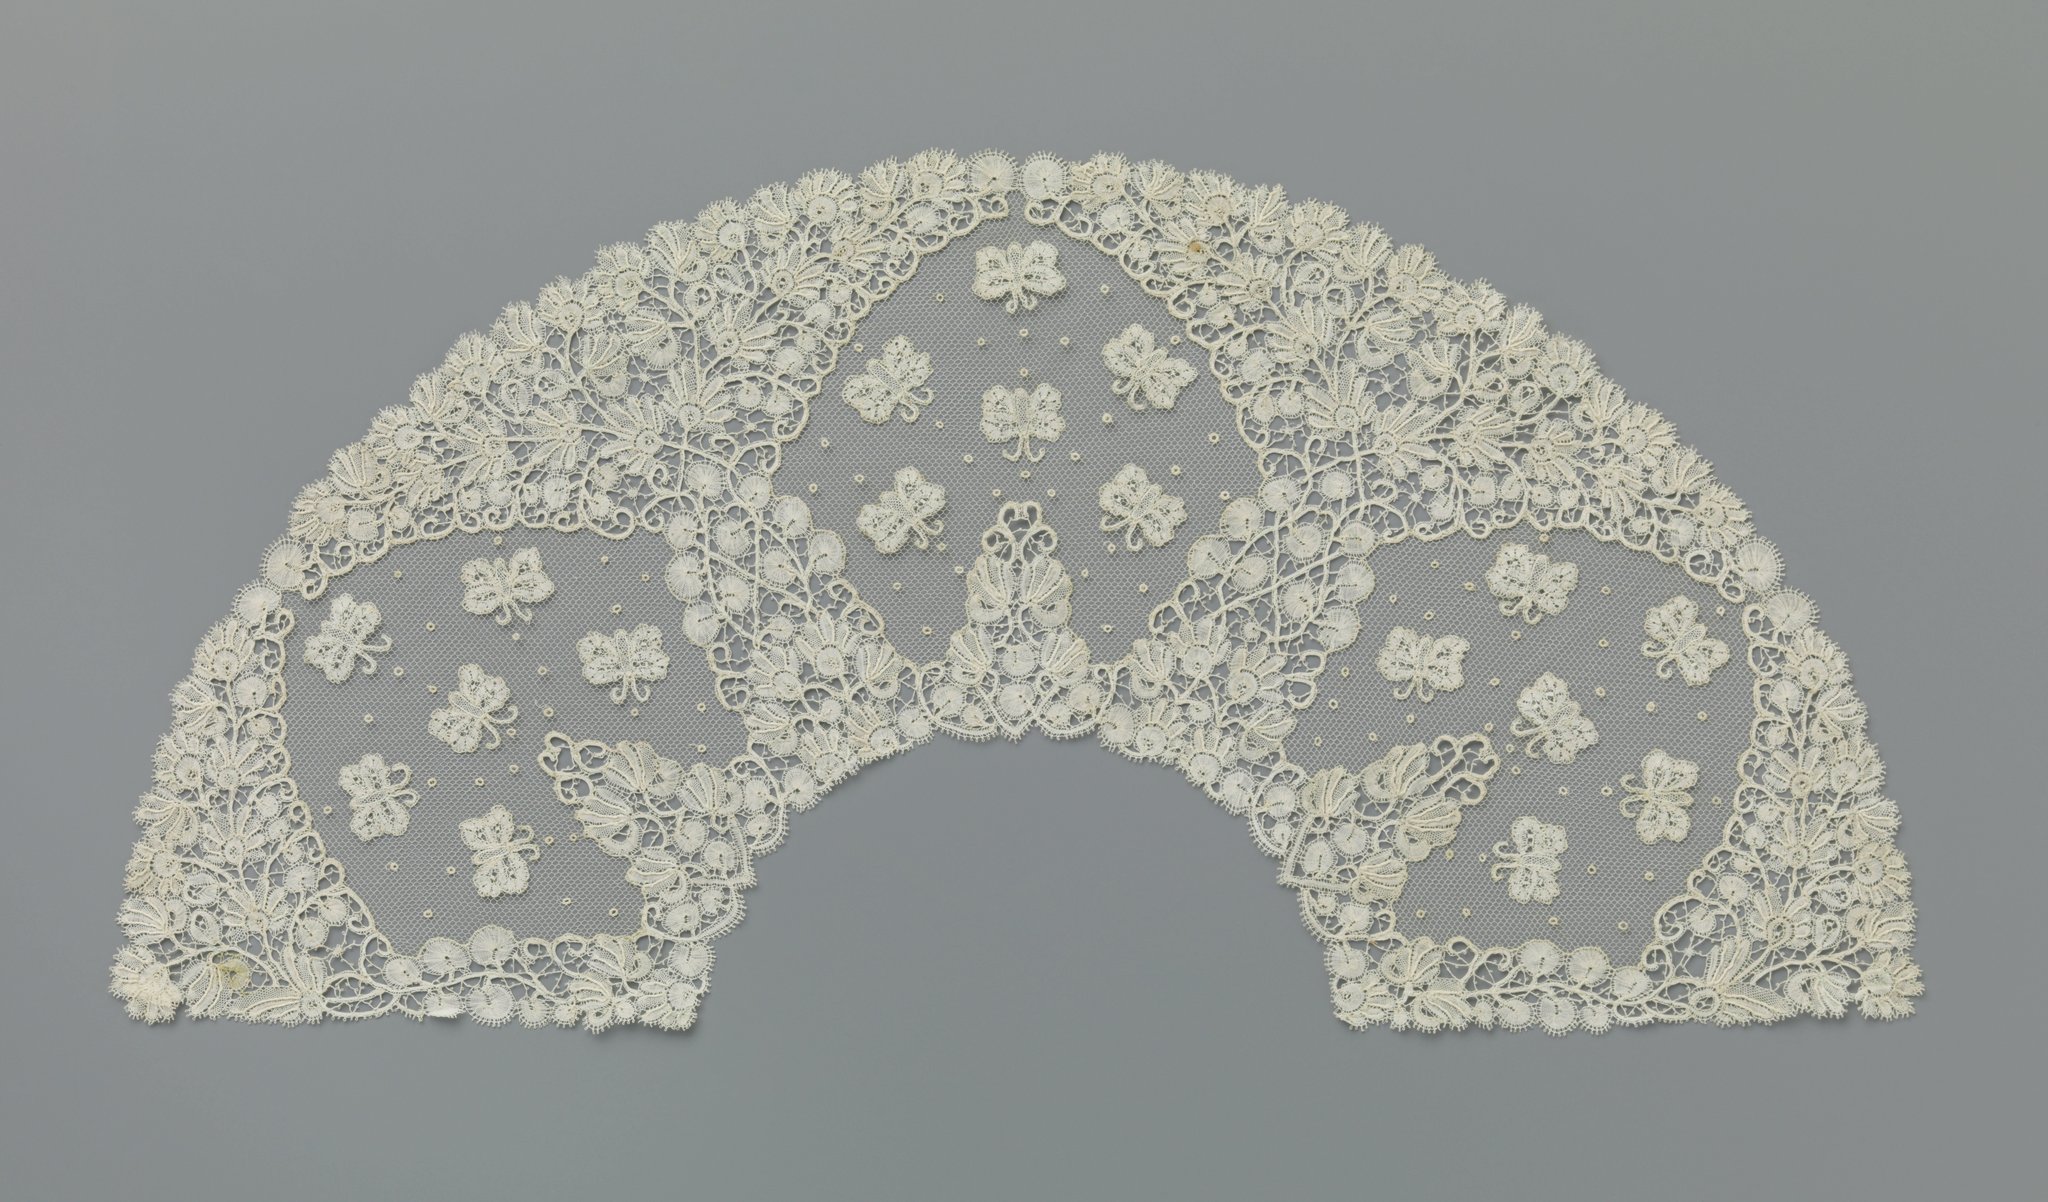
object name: waaierblad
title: Waaierblad van gemengde kant met vlindertjes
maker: Anonymous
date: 1910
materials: cotton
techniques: lace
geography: netherlands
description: Waaierblad van naturelkleurige gemengde kant: kloskant (duchesse-kant) met inzetstukken van applicatiekant (kloskant geappliceerd op machinale tule). Halfcirkelvormig. Symmetrisch patroon van drie grote reserves in schulpvorm (tule), waarop gestrooide vlinders geappliceerd zijn. Een omlijsting (kloskant) met vlechtengrond vertoont symmetrische, elkaar meermalen snijdende stengels met trossen aalbessen en handvormige blaadjes.